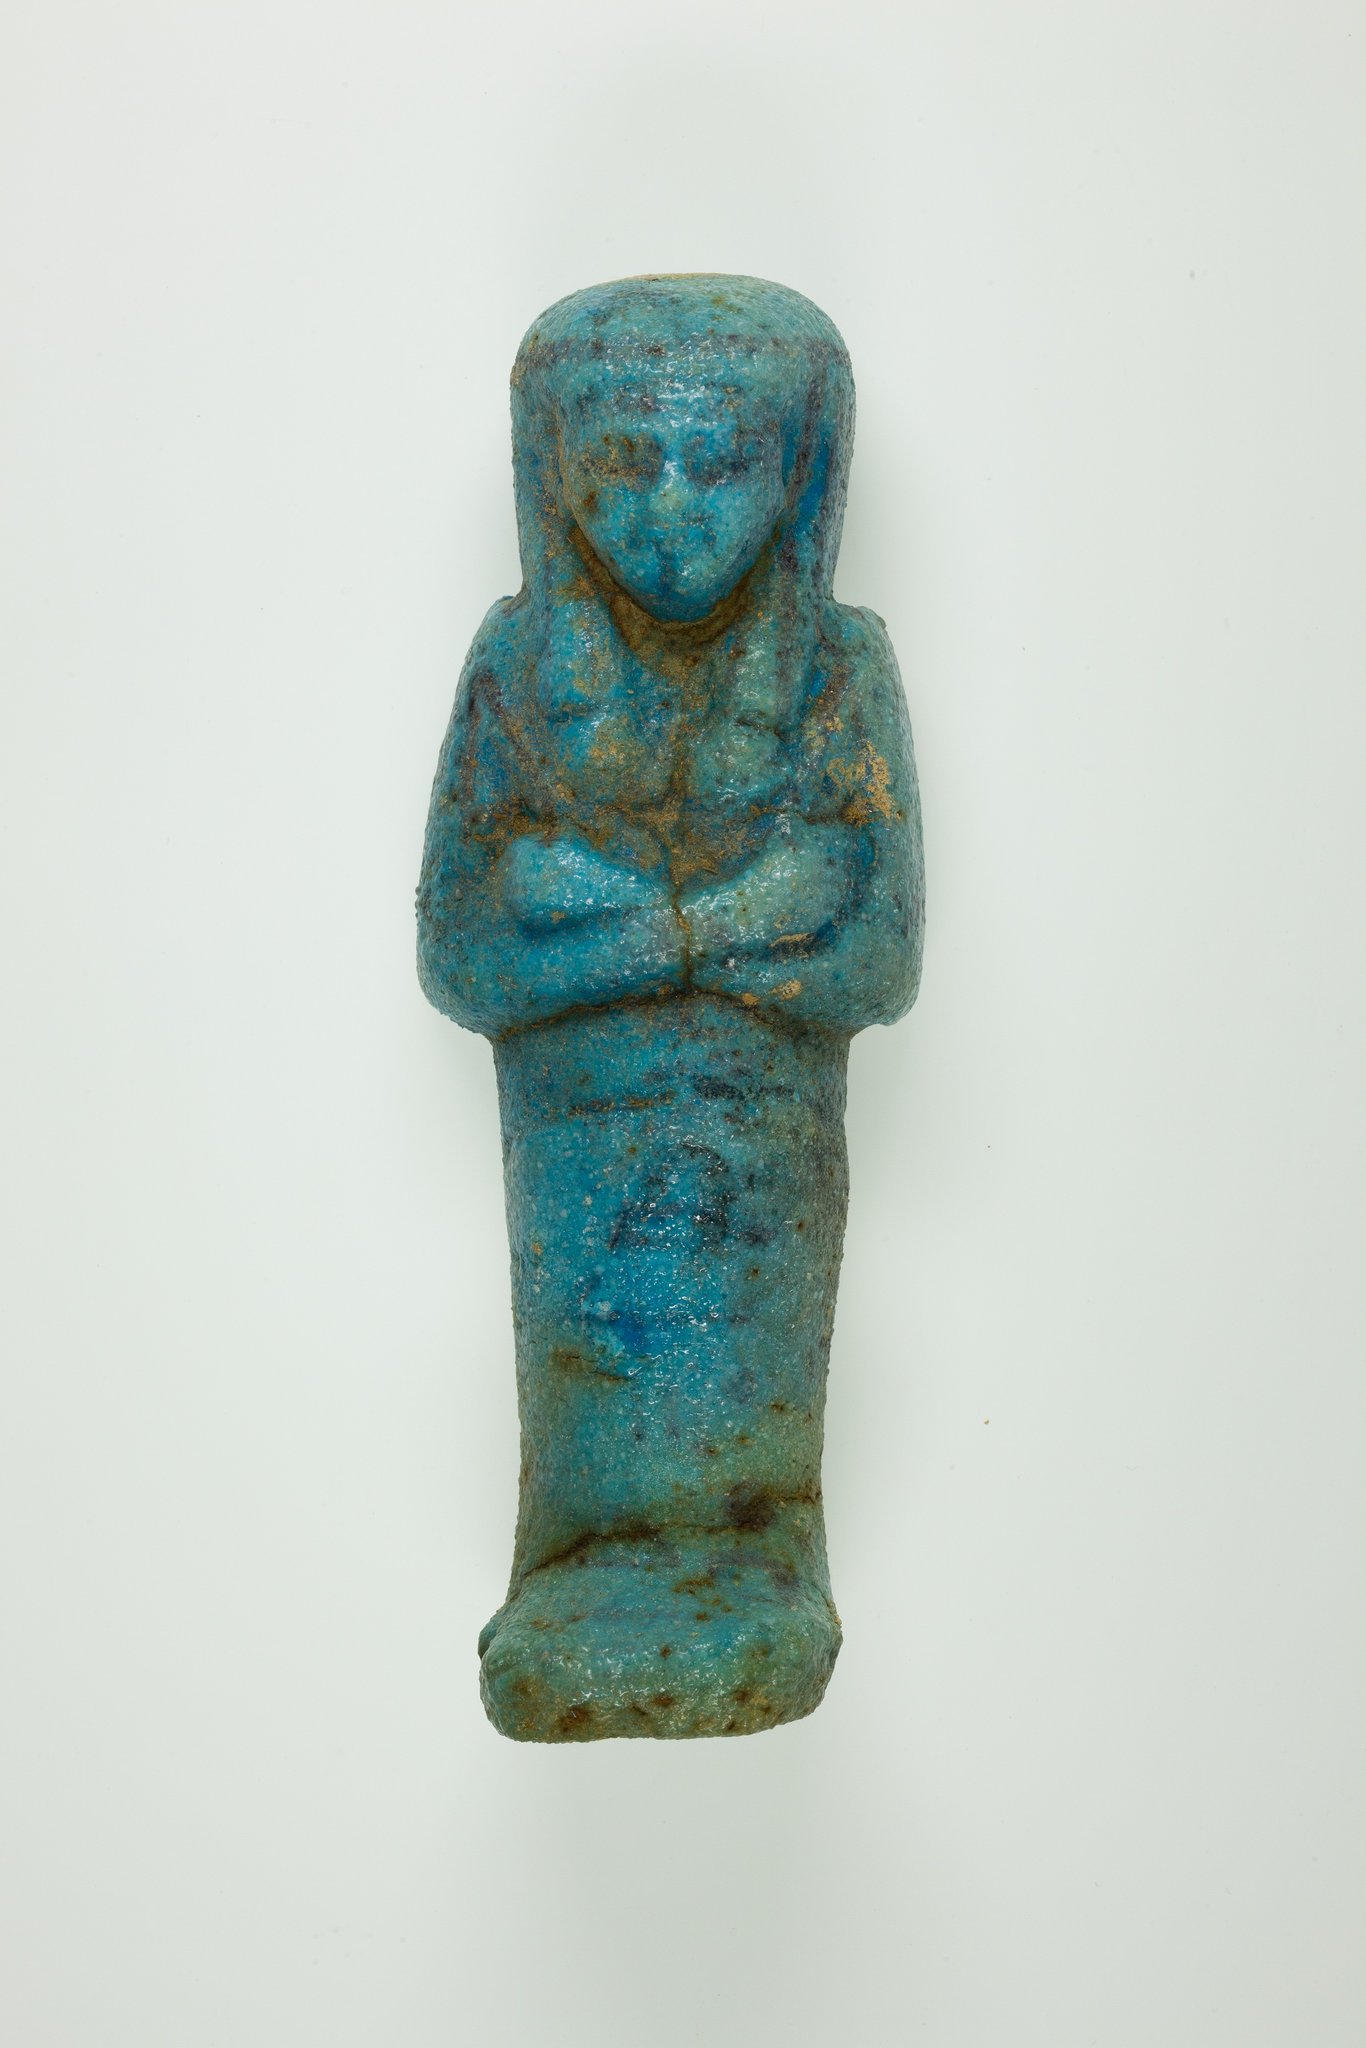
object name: worker shabti, henettawy c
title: Worker Shabti of Henettawy (C), Daughter of Isetemkheb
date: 990-970 BCE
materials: faience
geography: egypt